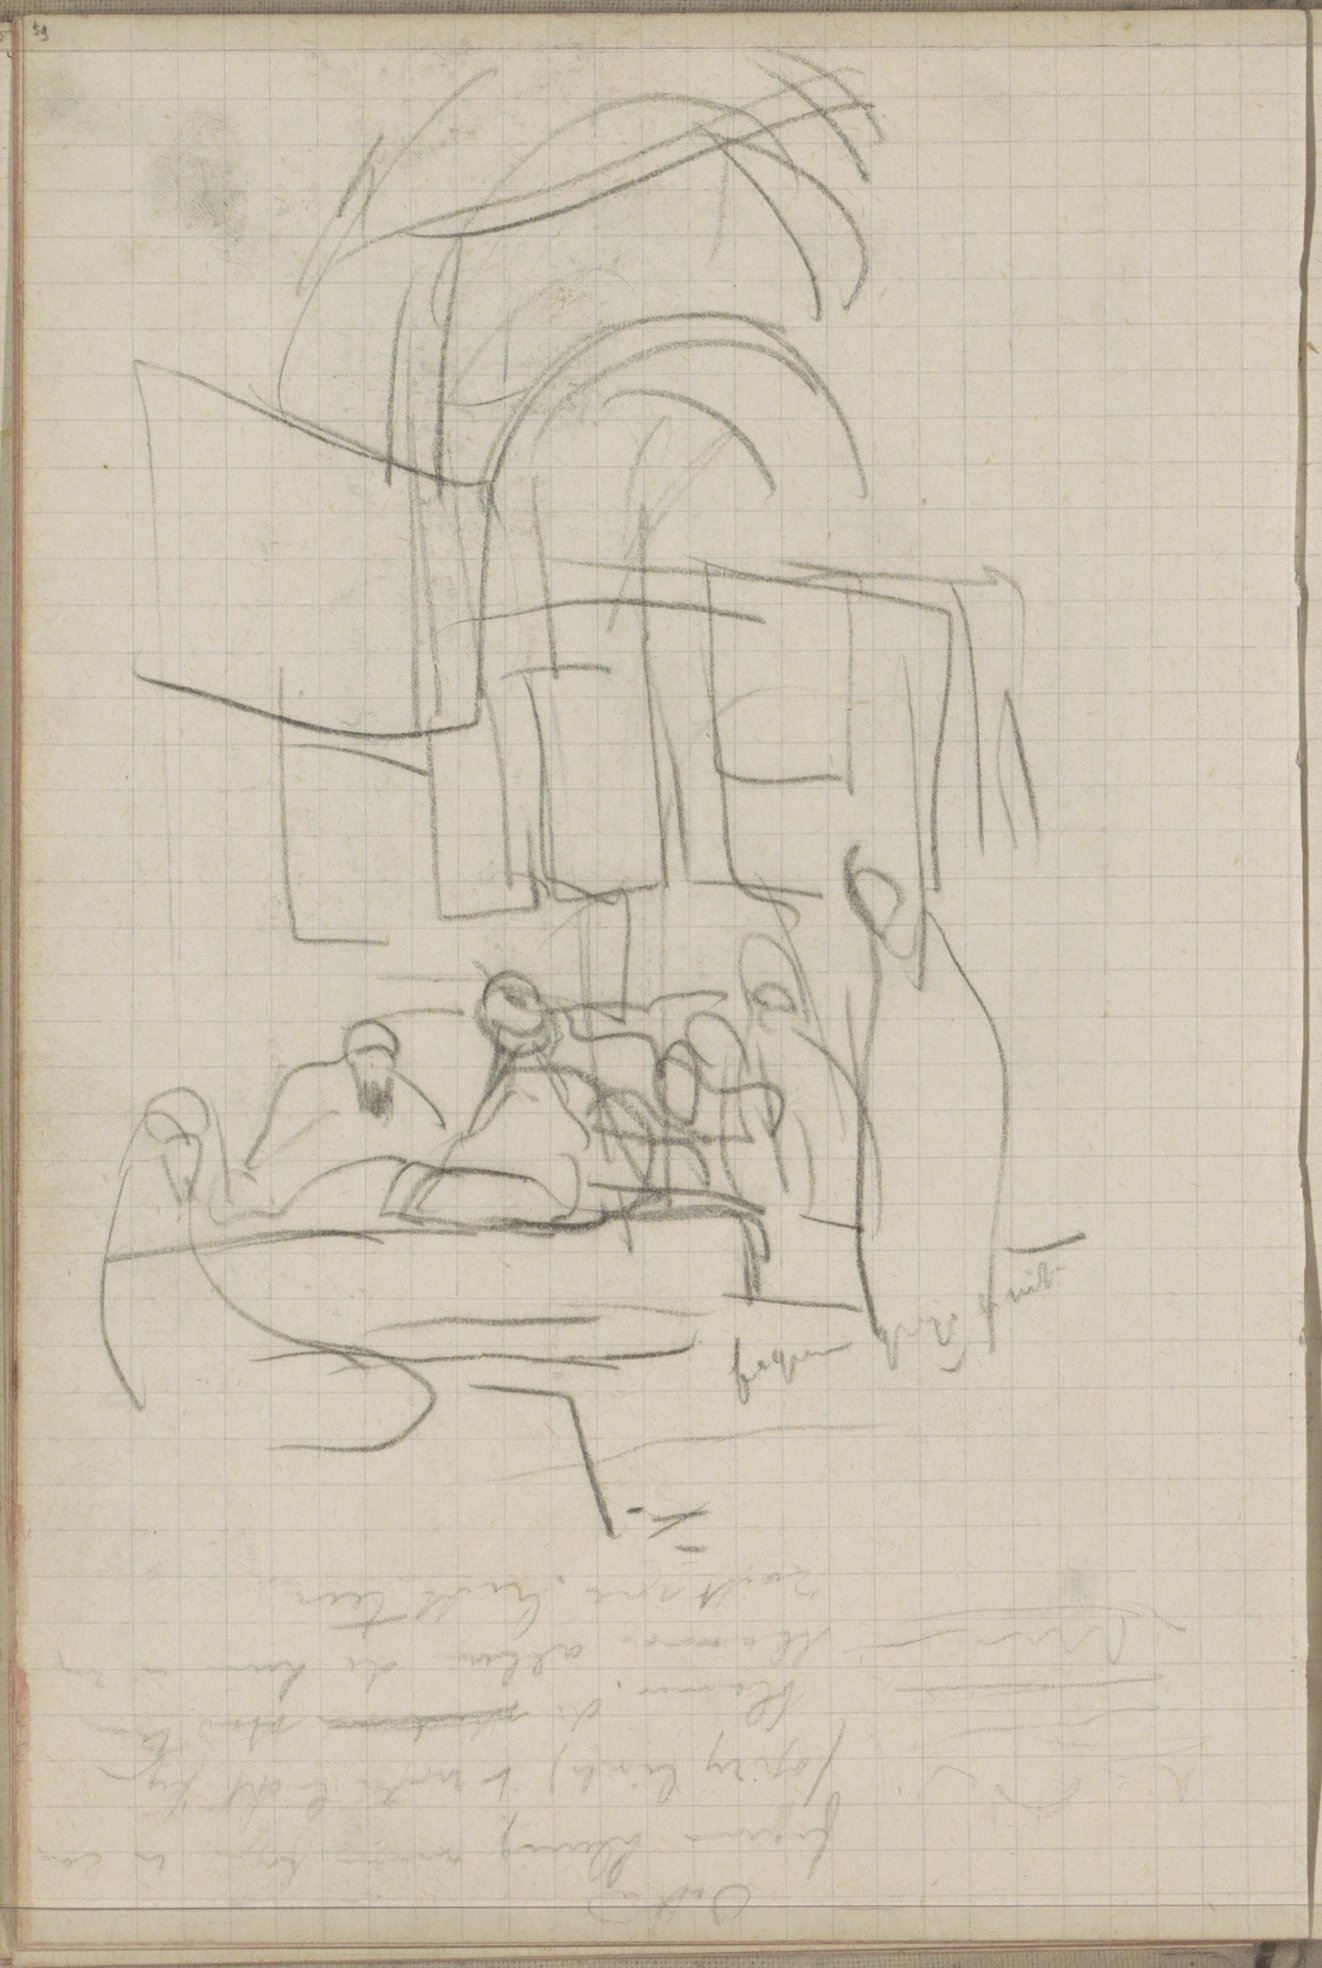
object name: sketchbook leaf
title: Groep figuren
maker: marius bauer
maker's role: draughtsman, print maker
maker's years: 1867-1932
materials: chalk, paper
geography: istanbul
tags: anatomy (non-medical), housing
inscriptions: kleurnotitie, handgeschreven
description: In of bij een gebouw. Pagina 59 uit een schetsboek met 51 bladen.